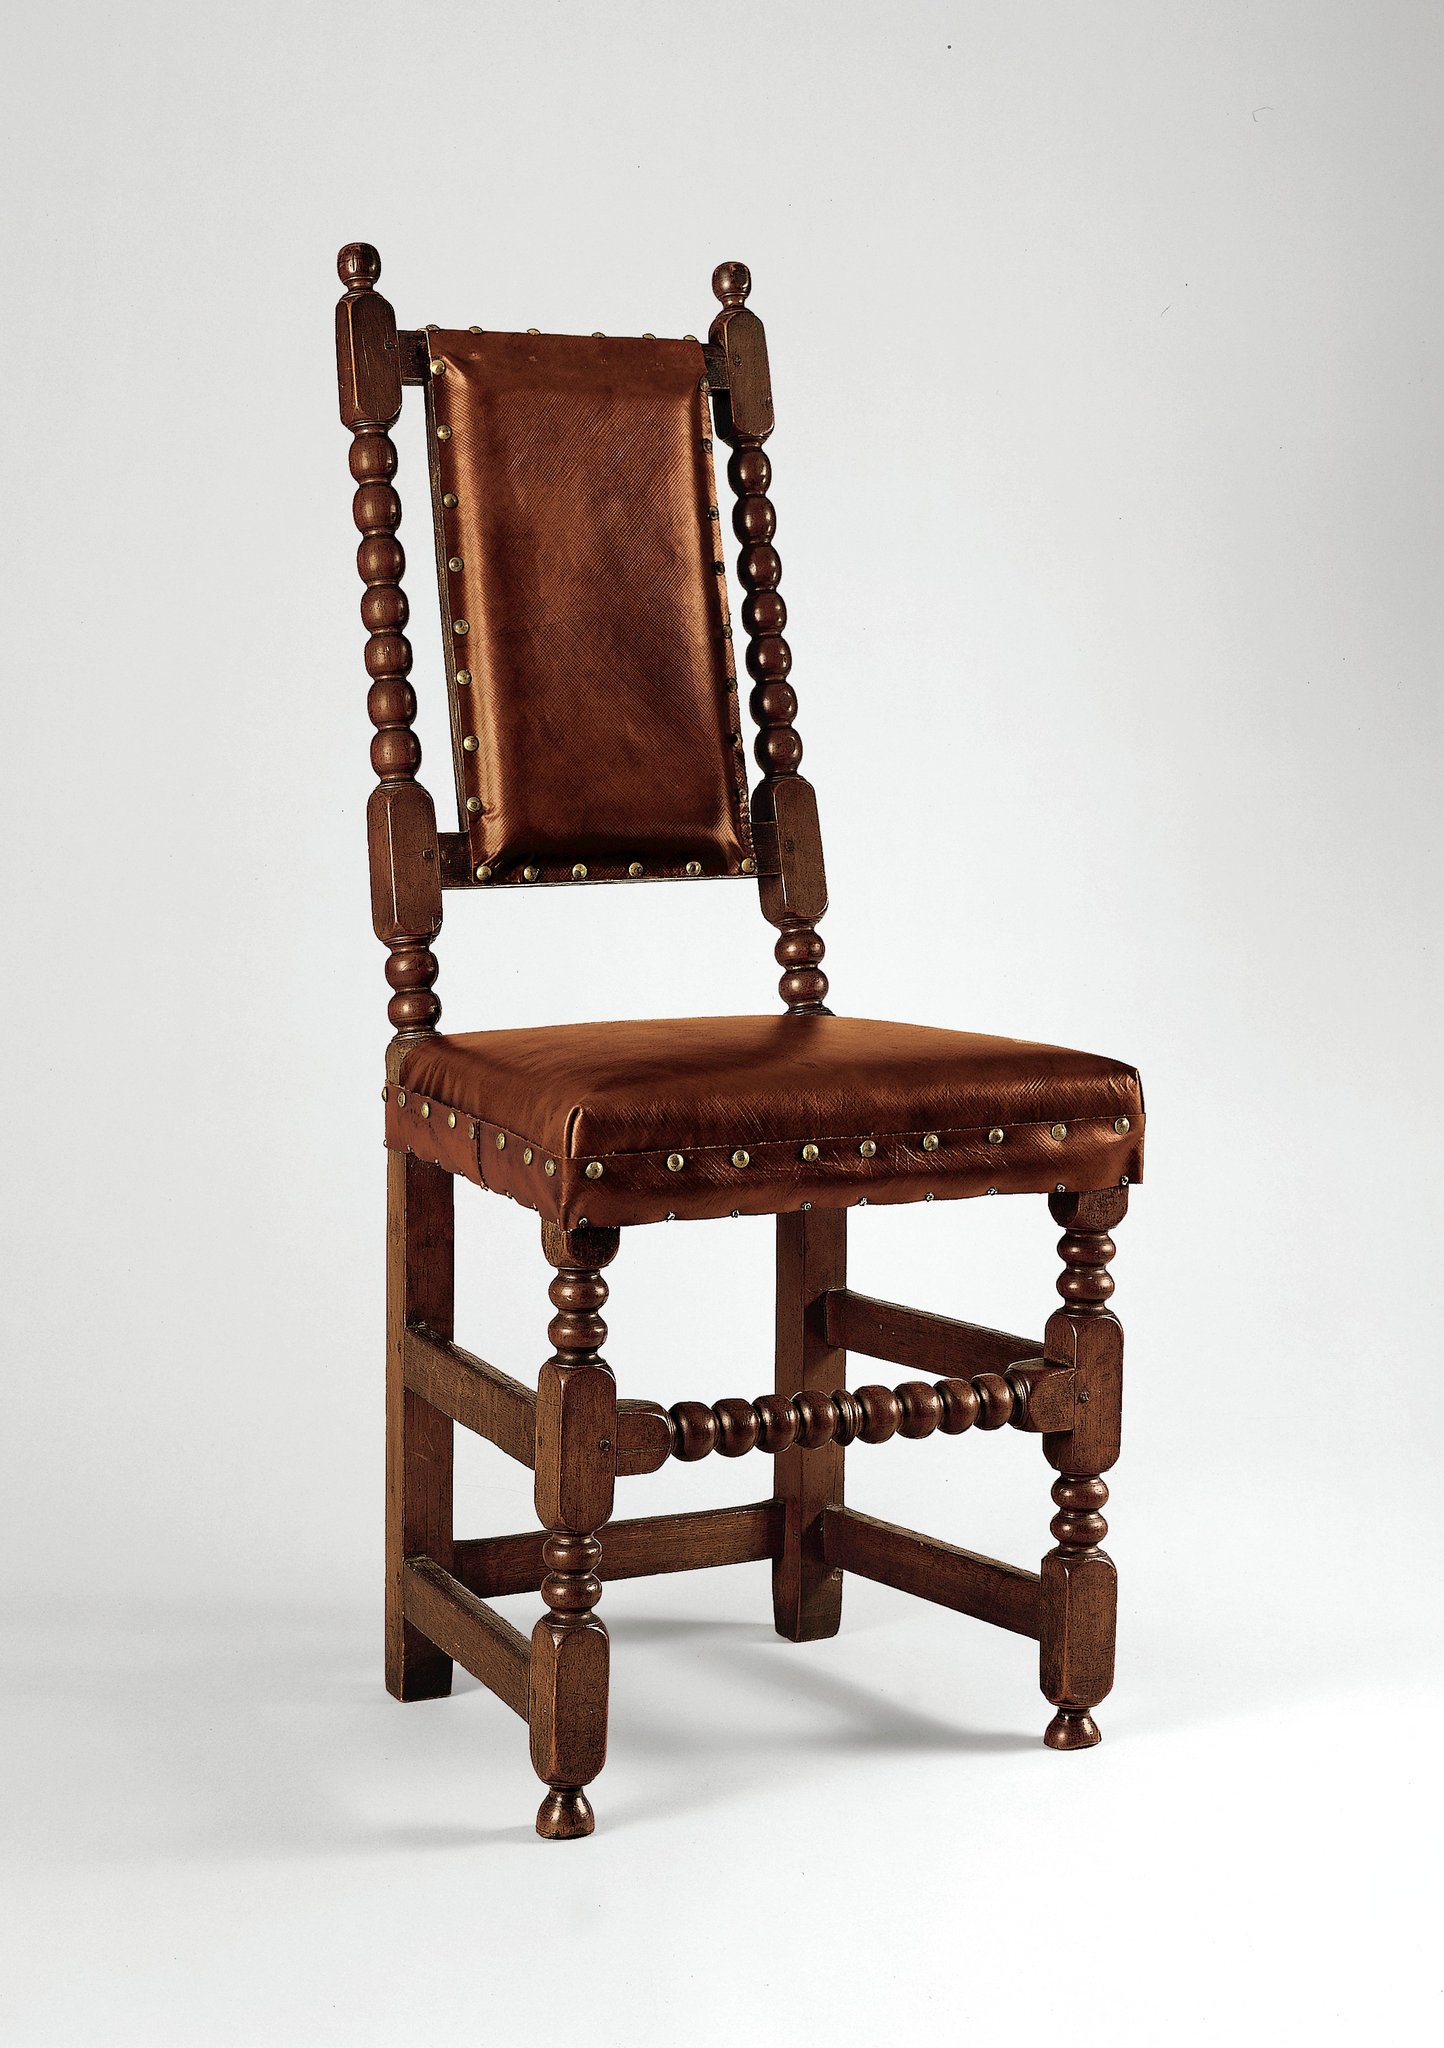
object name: side chair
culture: american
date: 1675-1700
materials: wood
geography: united states